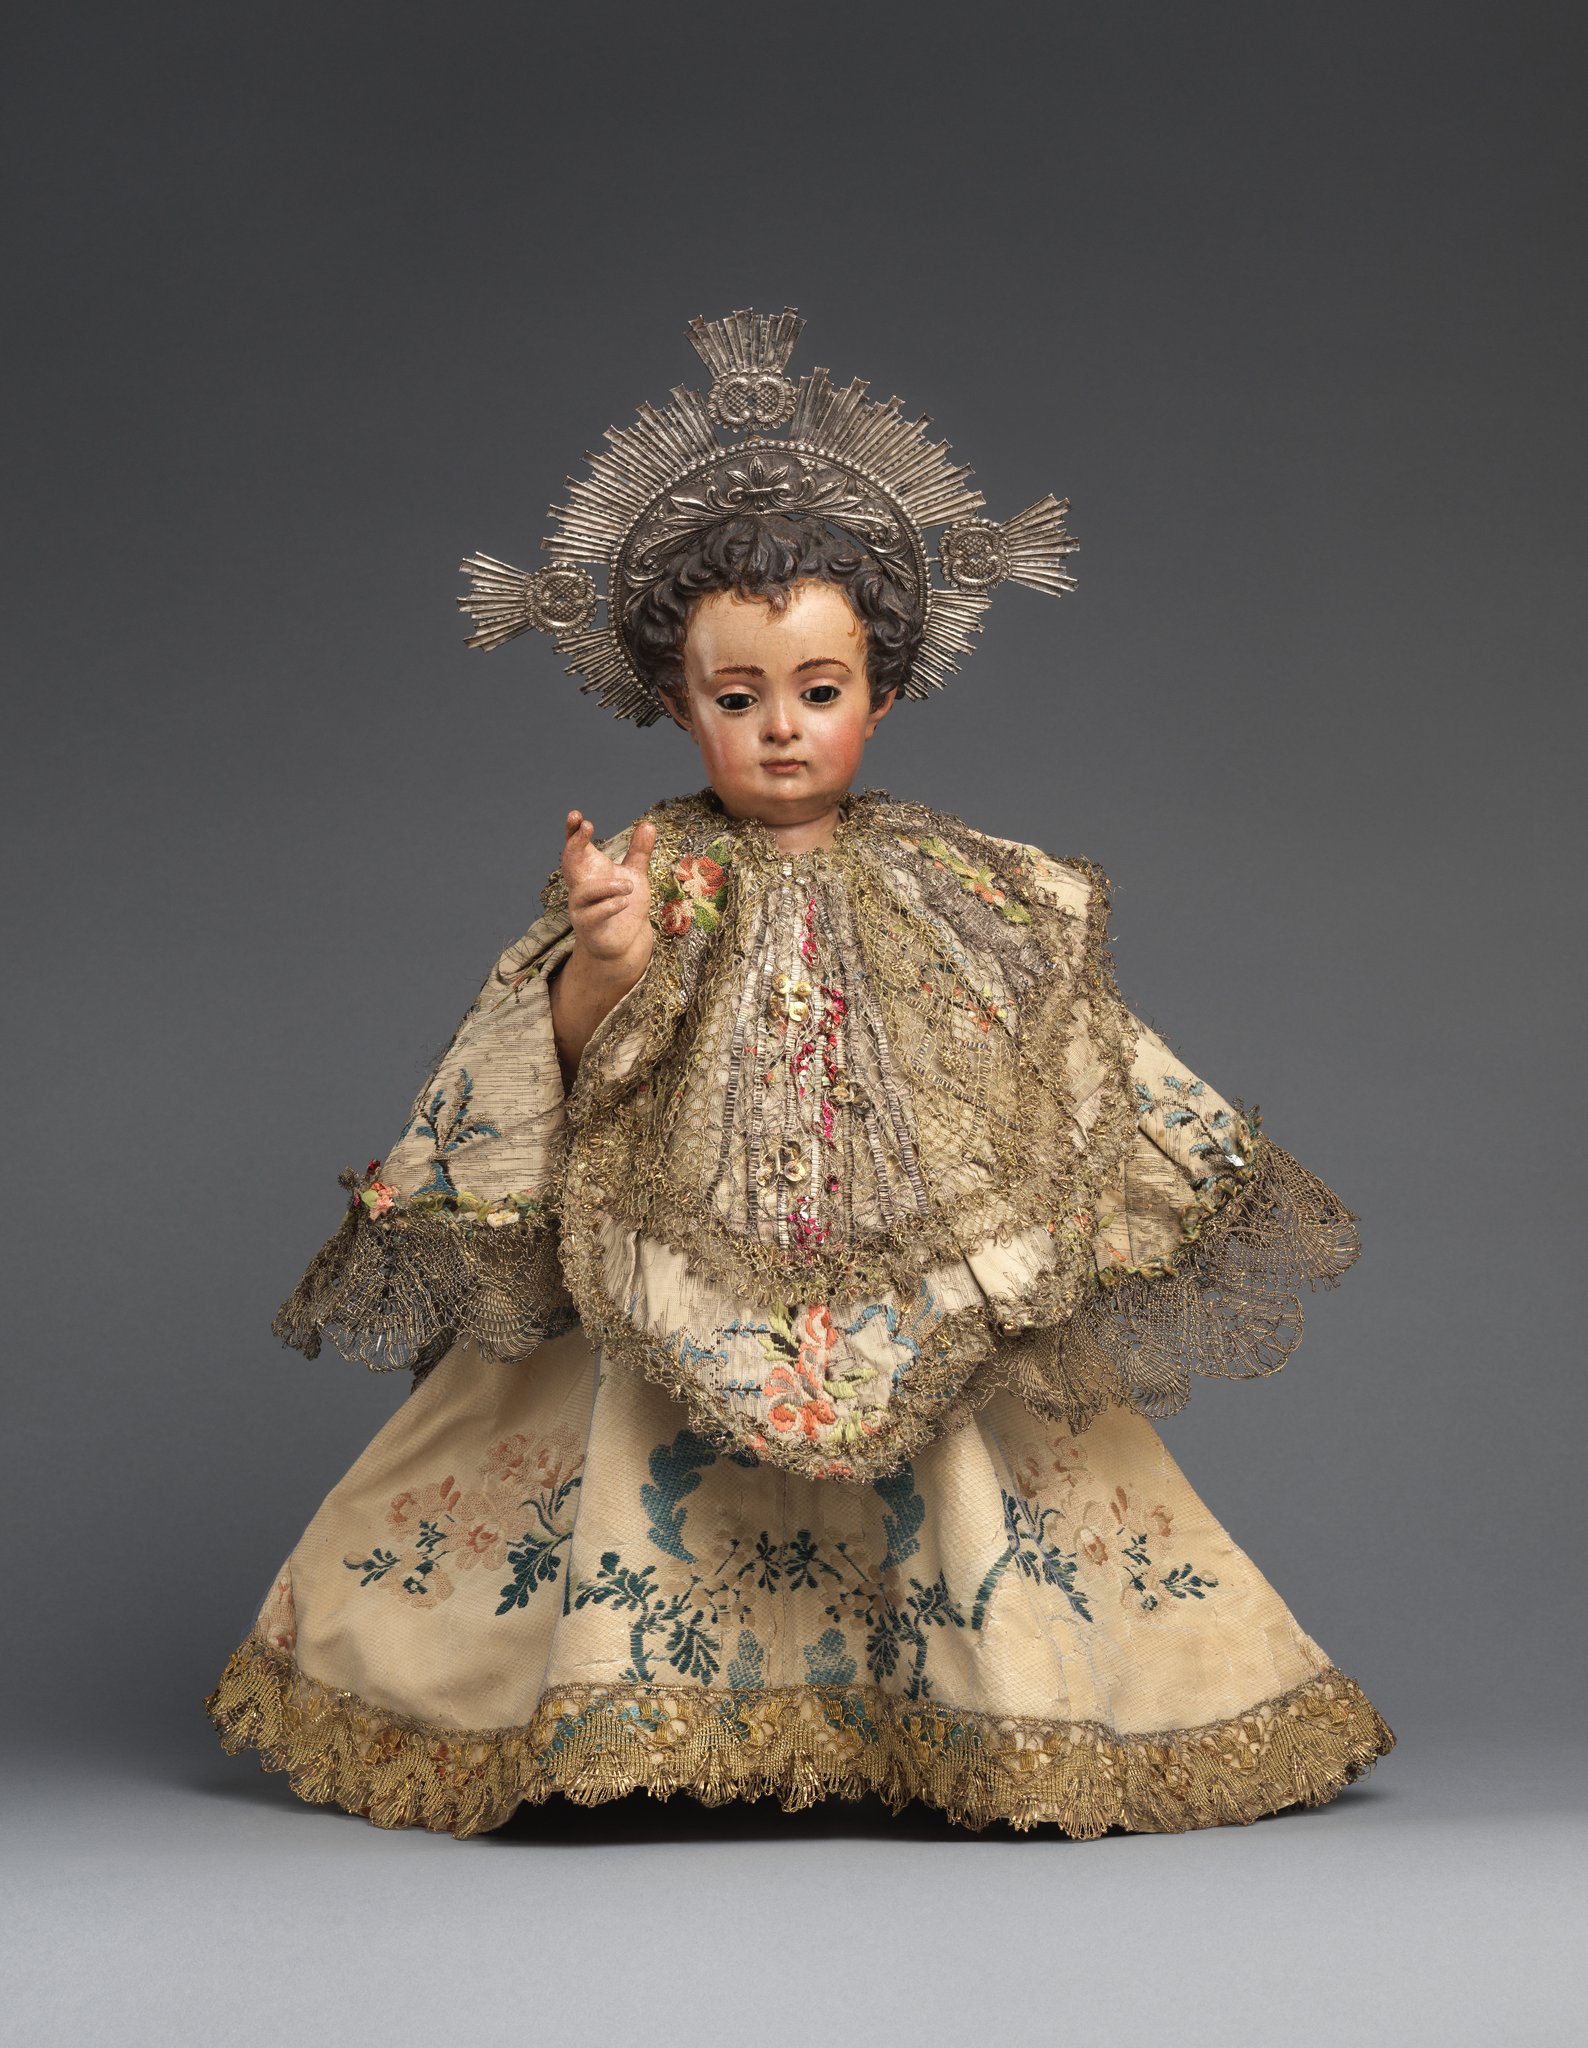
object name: statuette bib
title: Bib for a statutette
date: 1701-1800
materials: glass, lace, lead, silk, silver, silver gilt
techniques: polychrome